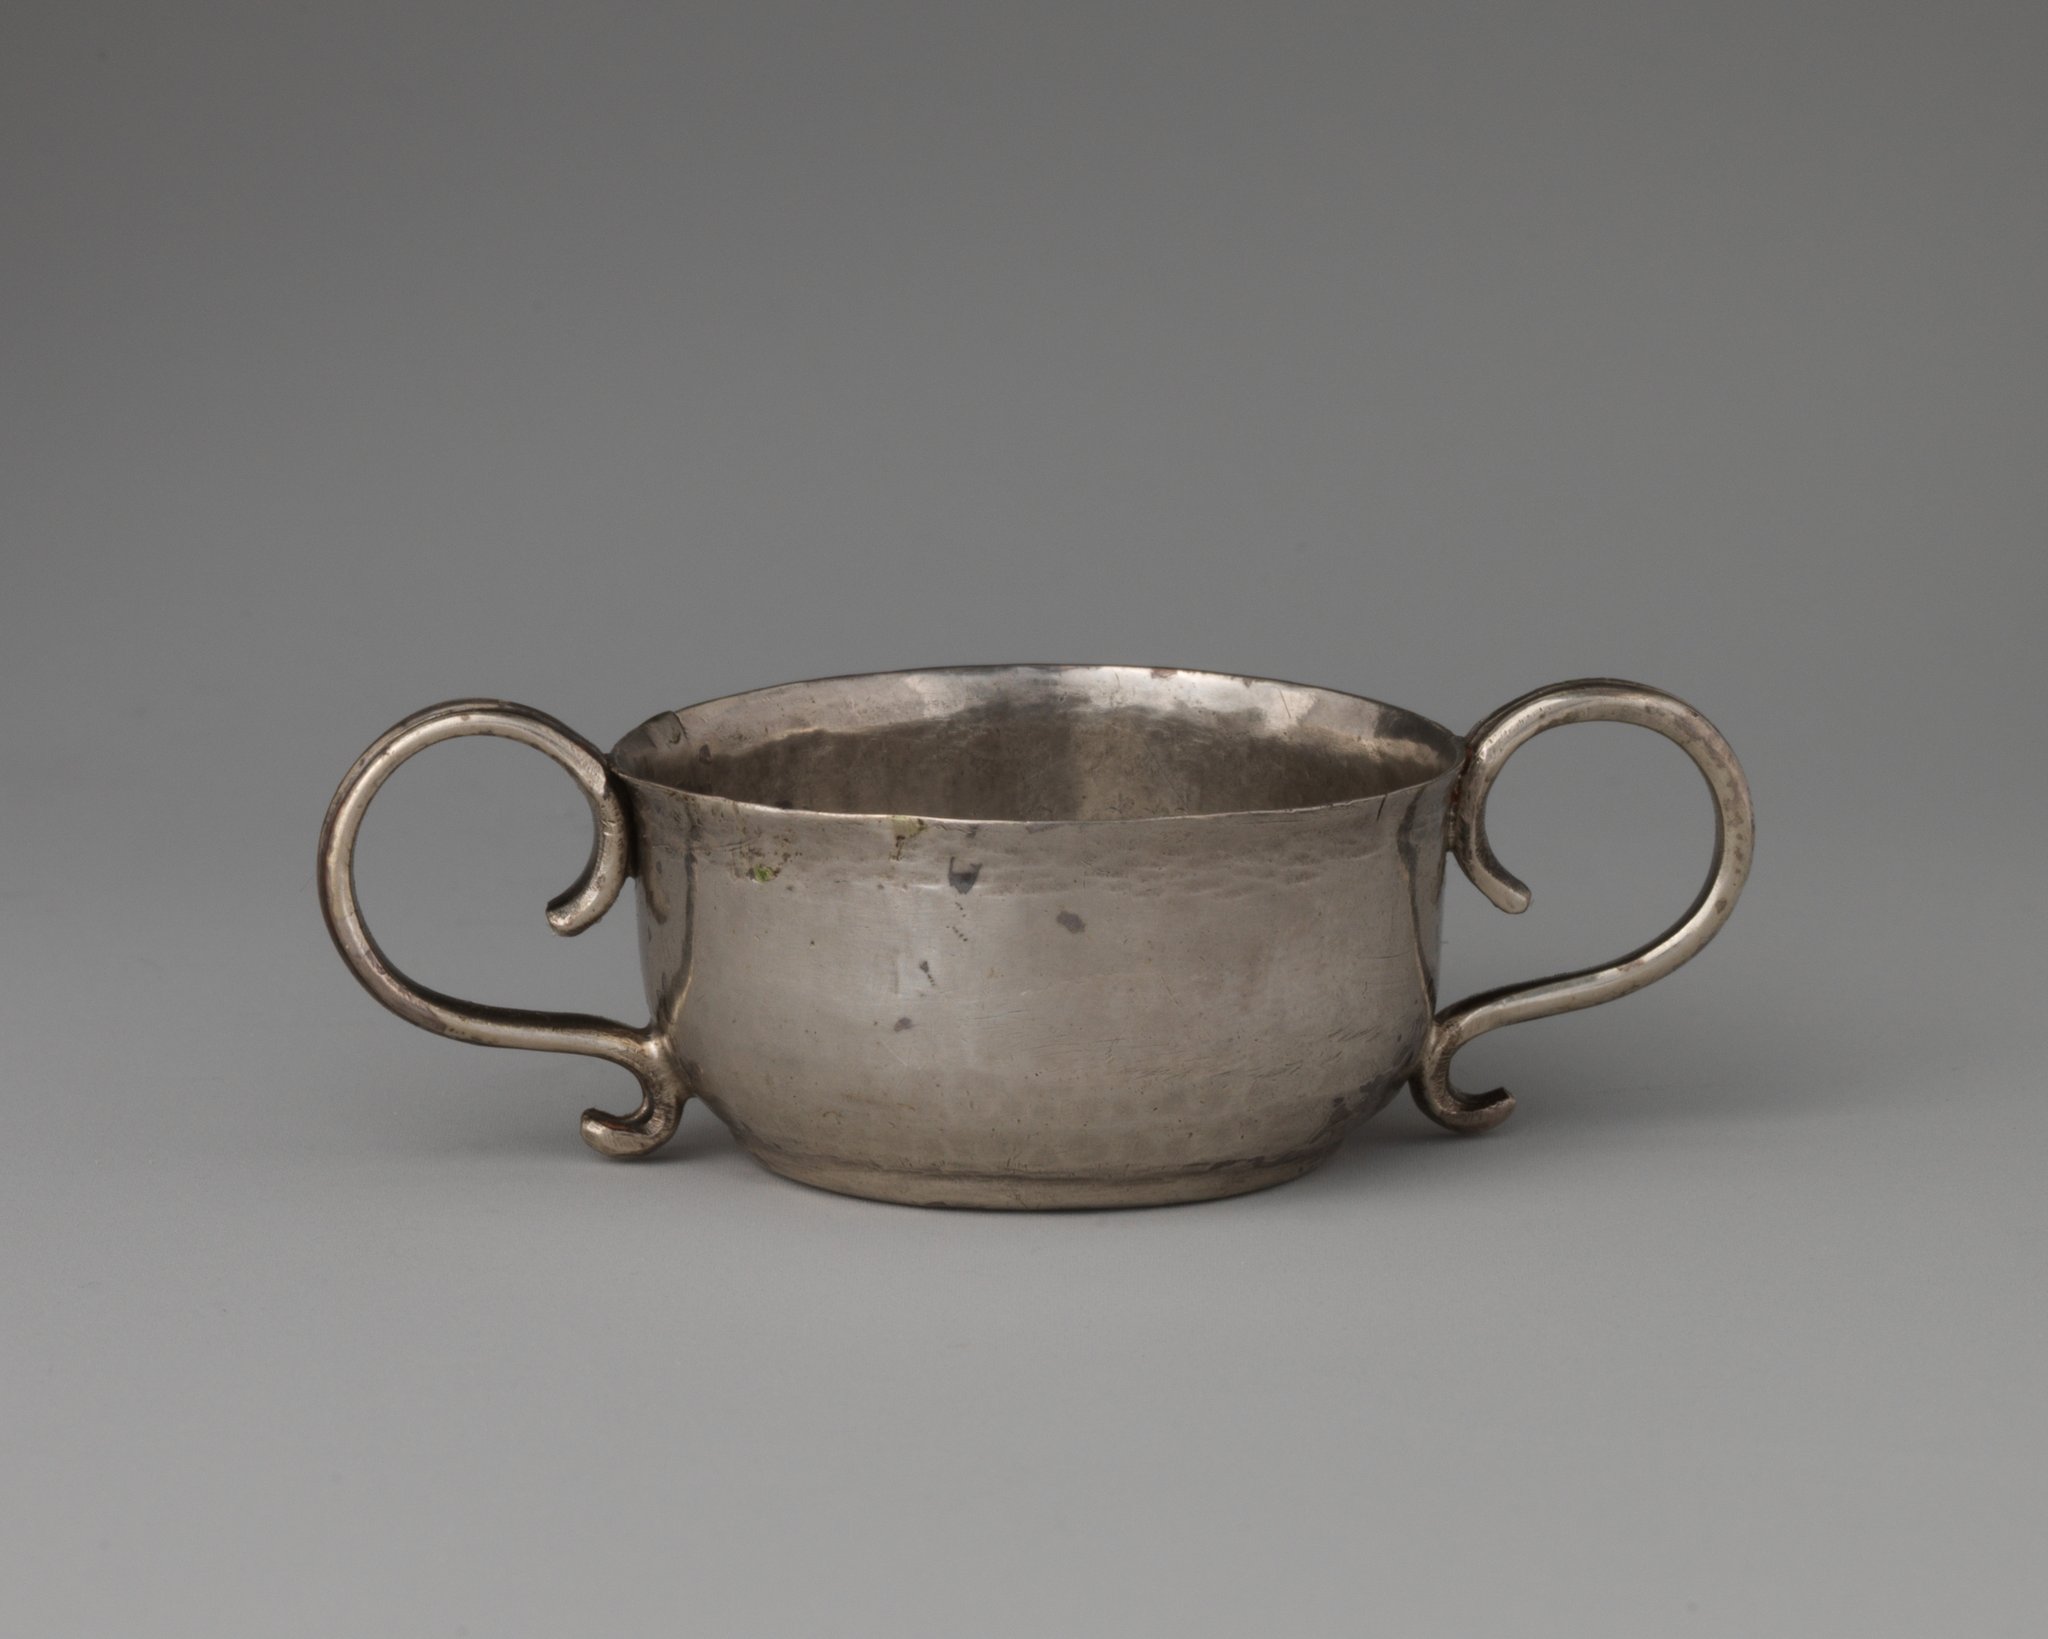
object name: porringer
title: Miniature porringer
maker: george manjoy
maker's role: maker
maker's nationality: british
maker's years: 1685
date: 1684-1685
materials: silver